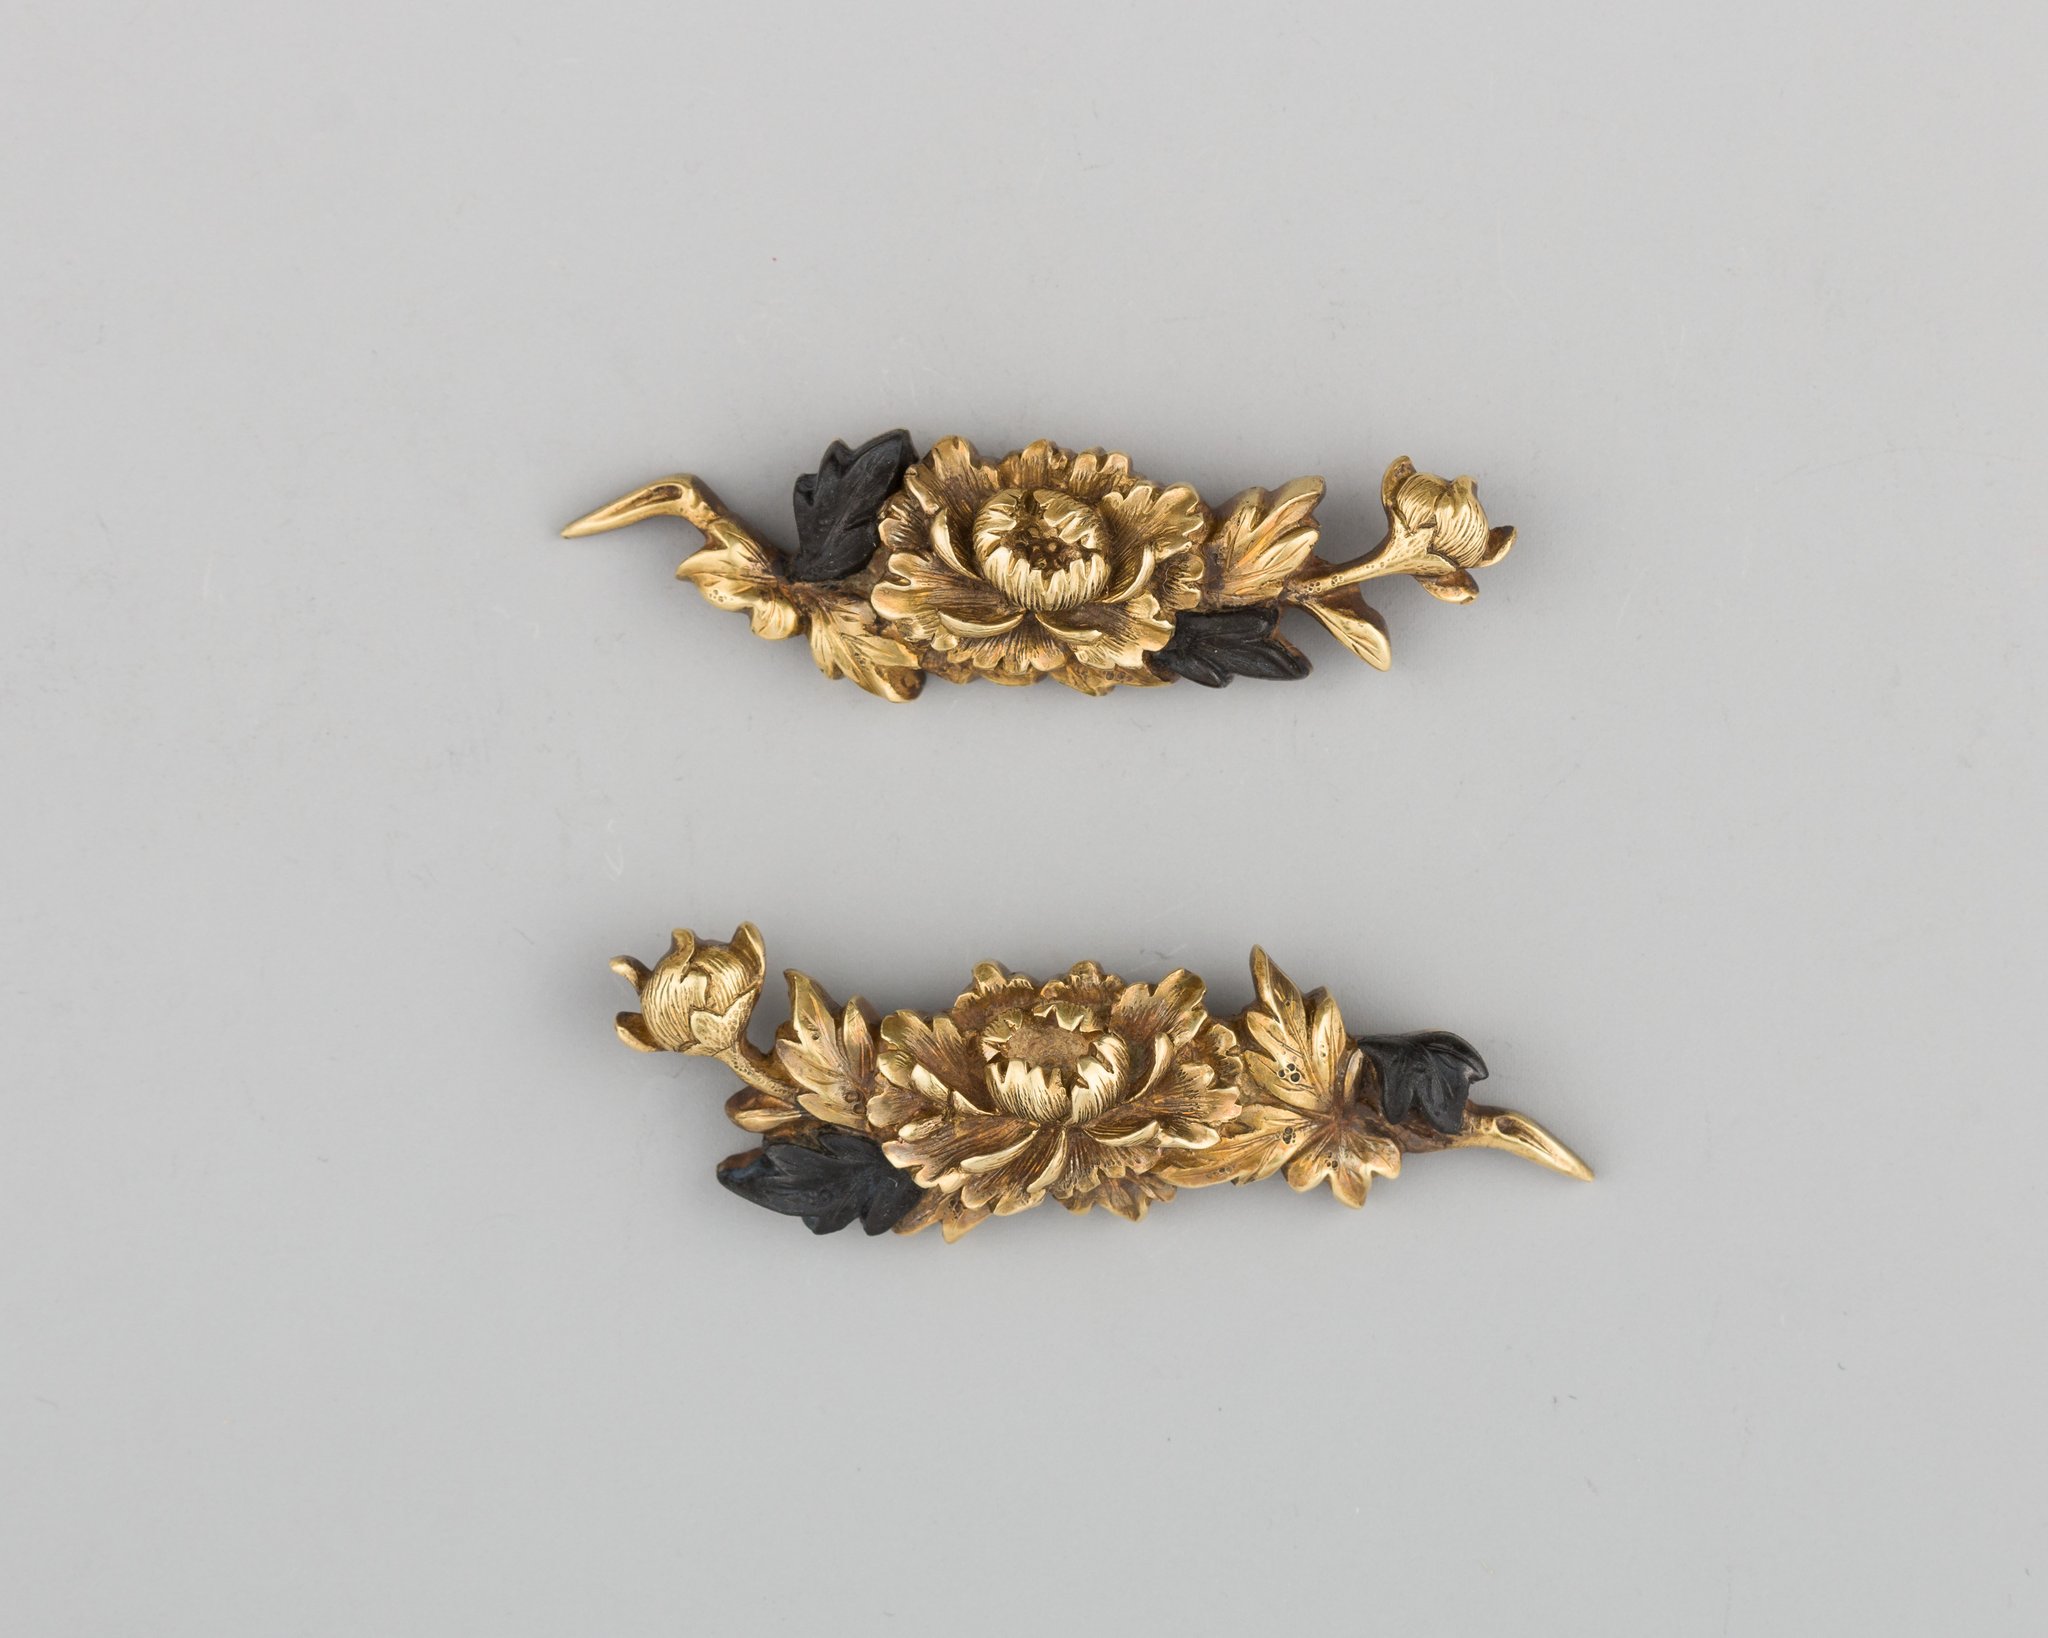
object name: pair of sword grip ornament menuki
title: Pair of Sword-Grip Ornaments (Menuki)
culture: japanese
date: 1701-1800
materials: gold alloy, gold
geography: japan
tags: flowers